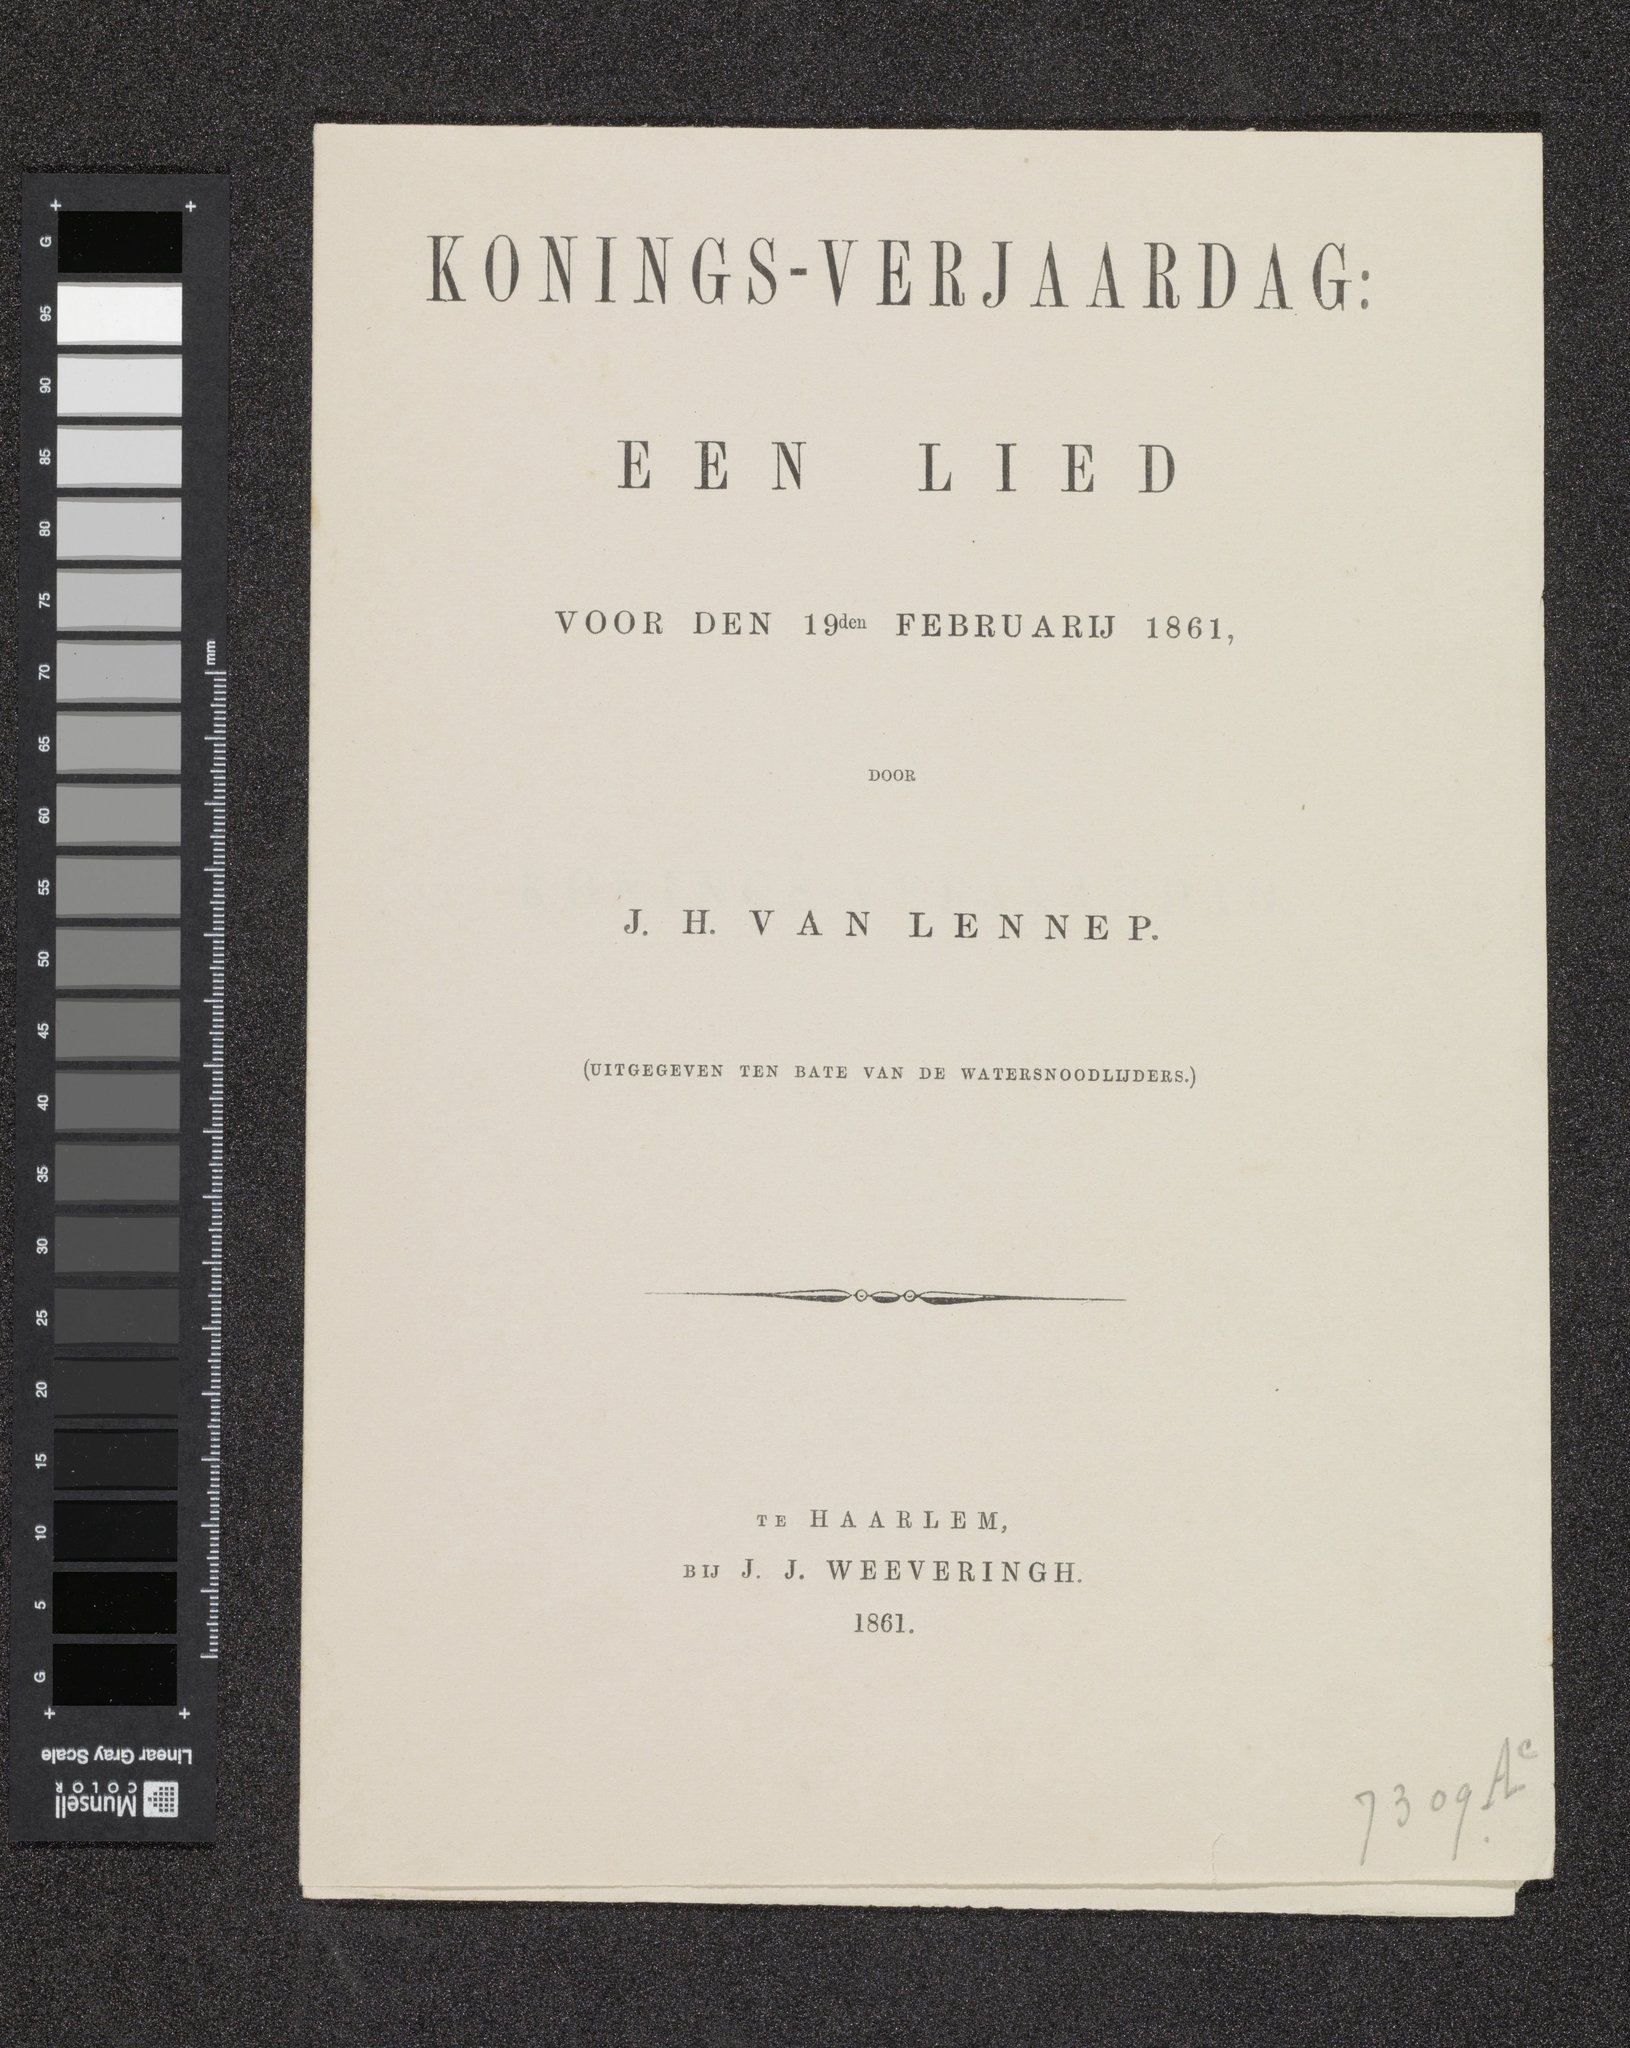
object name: text sheet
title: Konings-Verjaardag: een lied voor den 19den februarij 1861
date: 1861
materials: paper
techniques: letterpress printing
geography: haarlem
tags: brussels, willem iii (koning der nederlanden)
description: Vers ter gelegenheid van de 44ste verjaardag van koning Willem III op 19 februari 1861. Uitgegeven ten bate van de slachtoffers van de watersnood van januari-februari 1861. Onversneden blad in vieren gevouwen, het vers op p. 5-8. Het vers geschreven op 12 februari 1861.